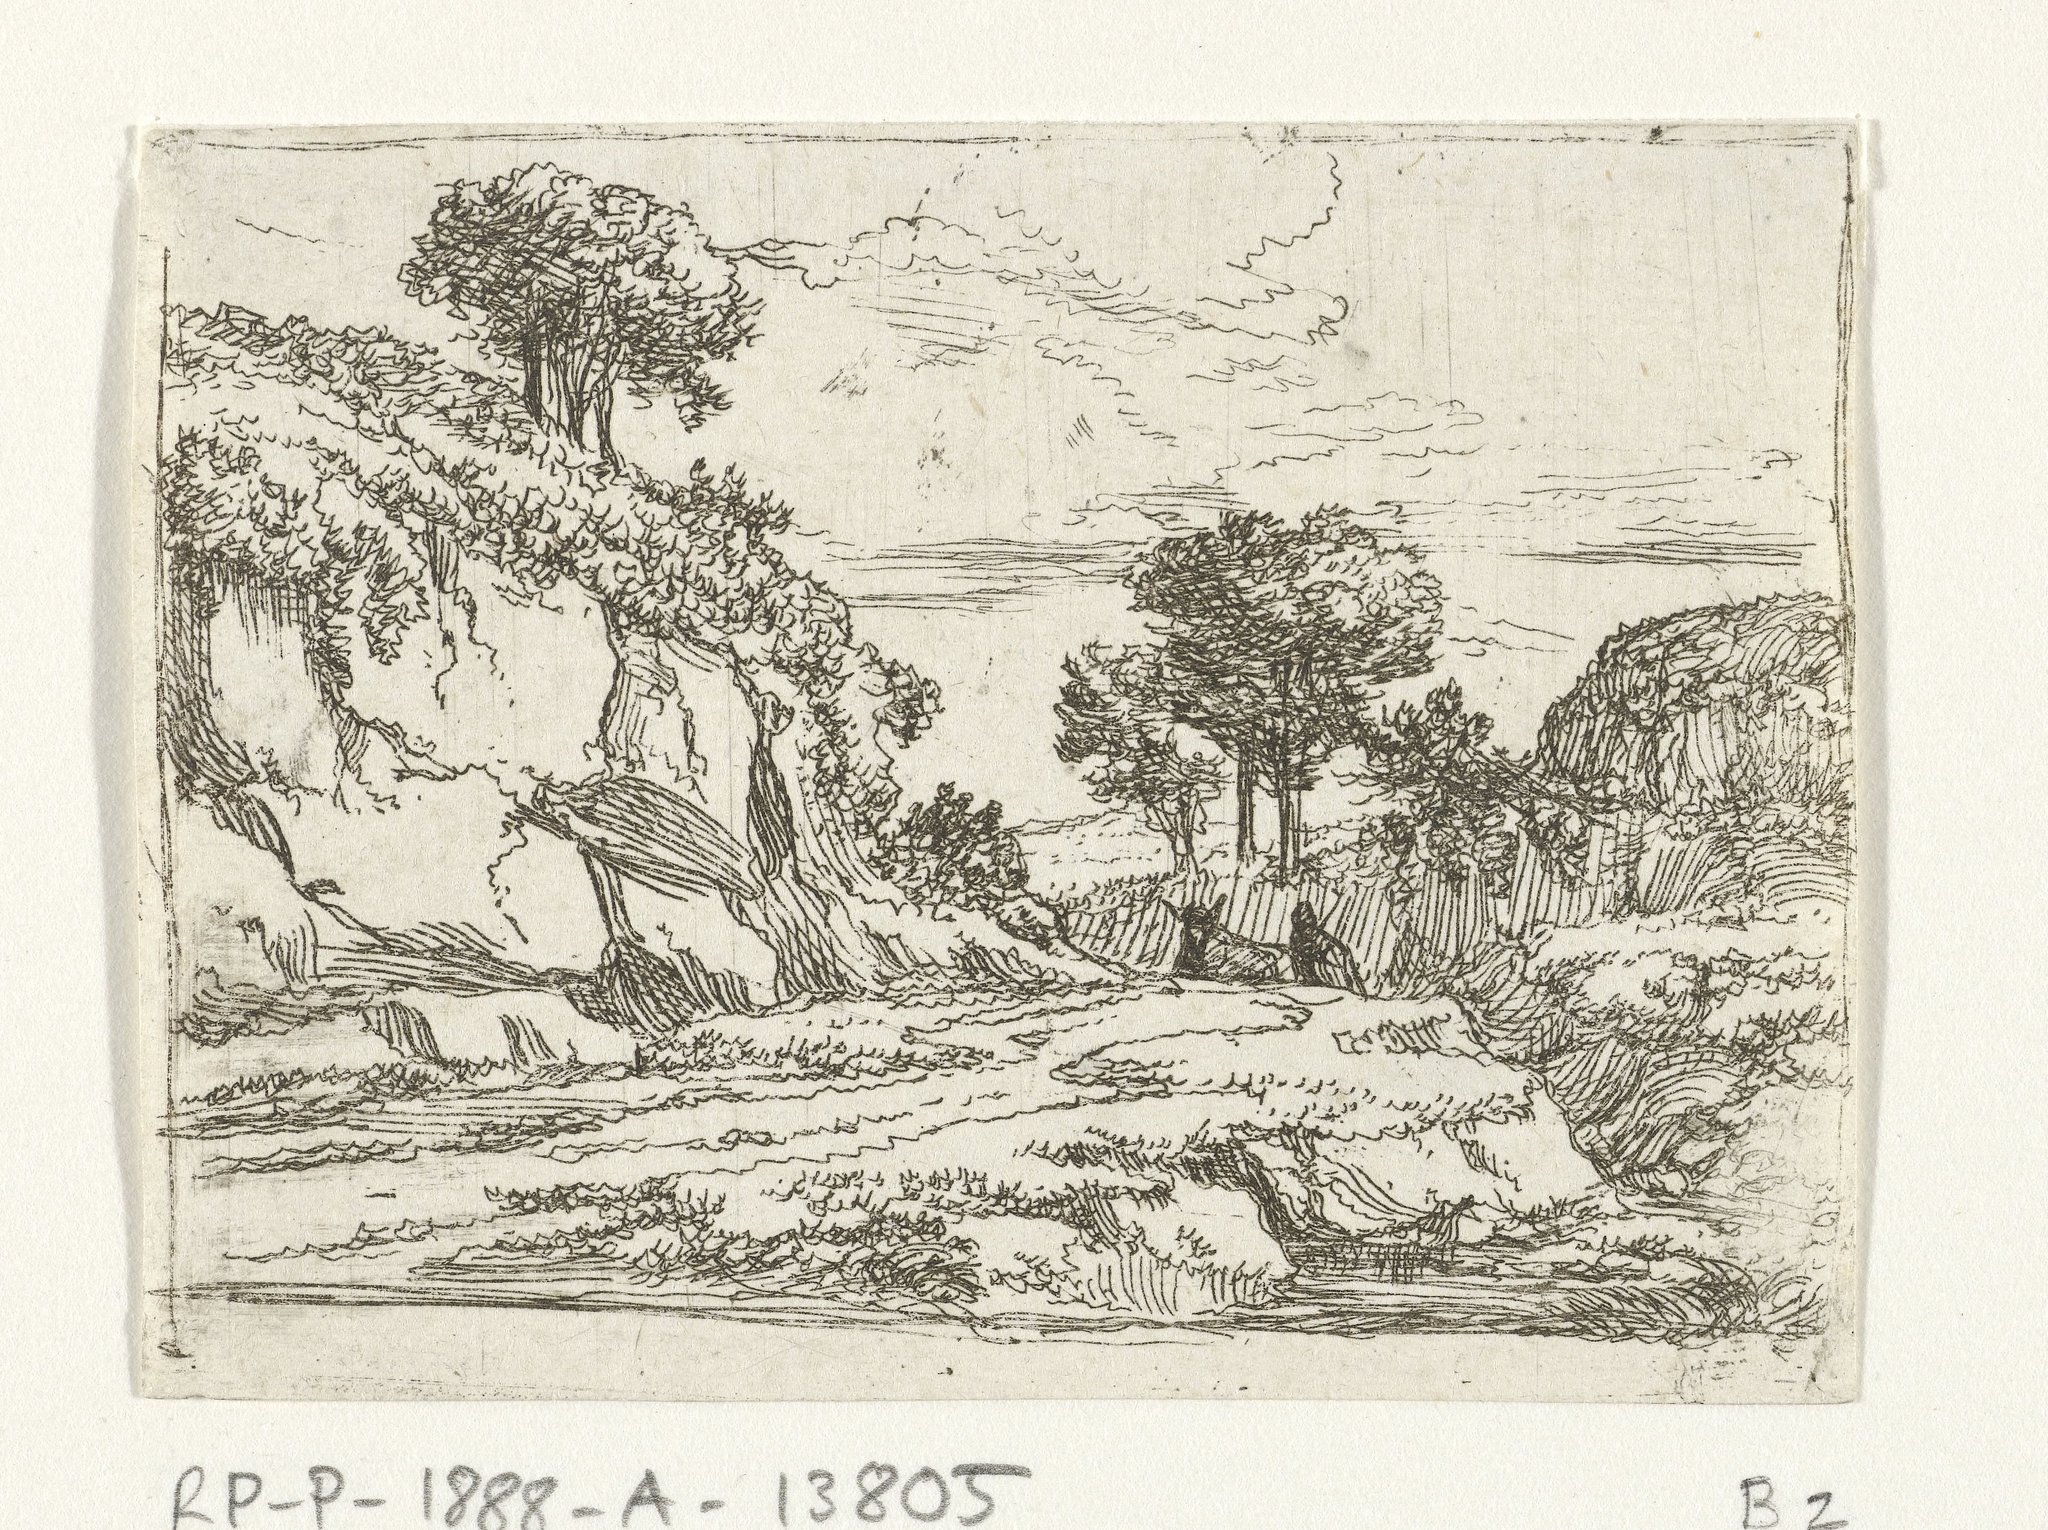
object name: print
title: Rotslandschap met ezelhoeder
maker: jan van ossenbeeck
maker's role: print maker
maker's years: 1623-1674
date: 1647-1674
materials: paper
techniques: etching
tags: ass, donkey, rocks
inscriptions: collector's mark: Lugt 2228